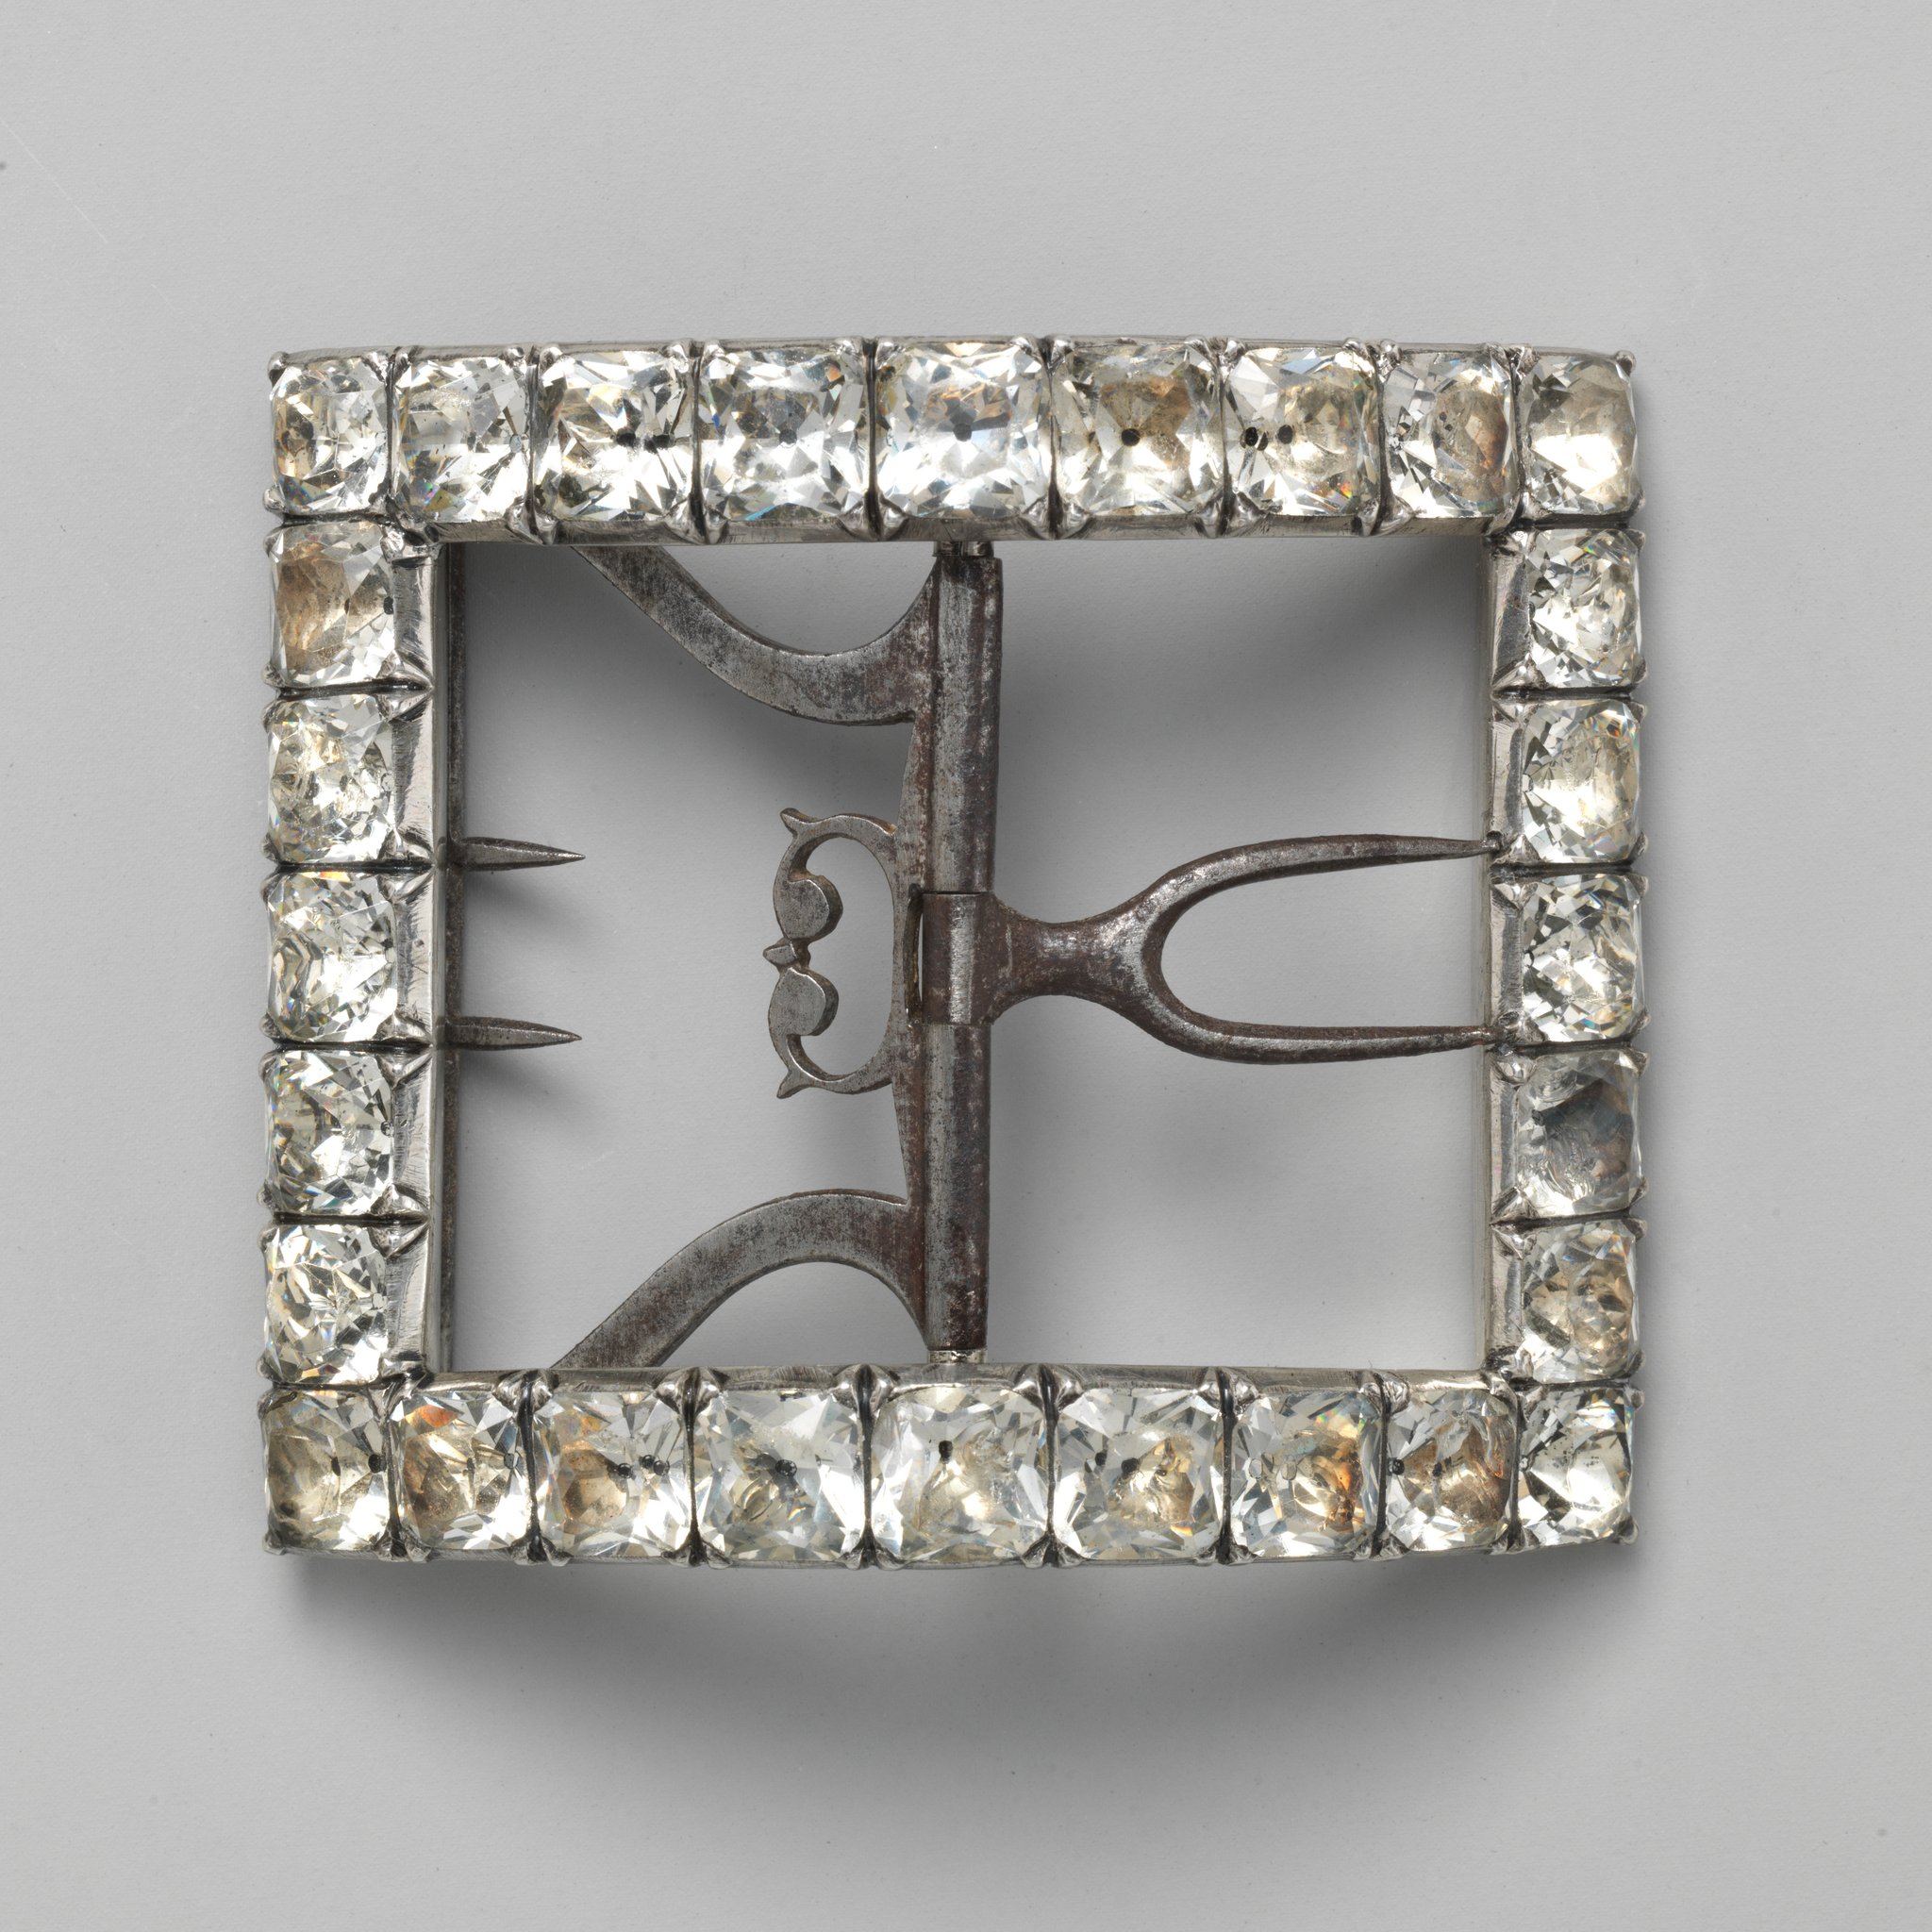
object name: shoe buckle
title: Shoe buckles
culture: british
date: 1767-1800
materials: metal, paste